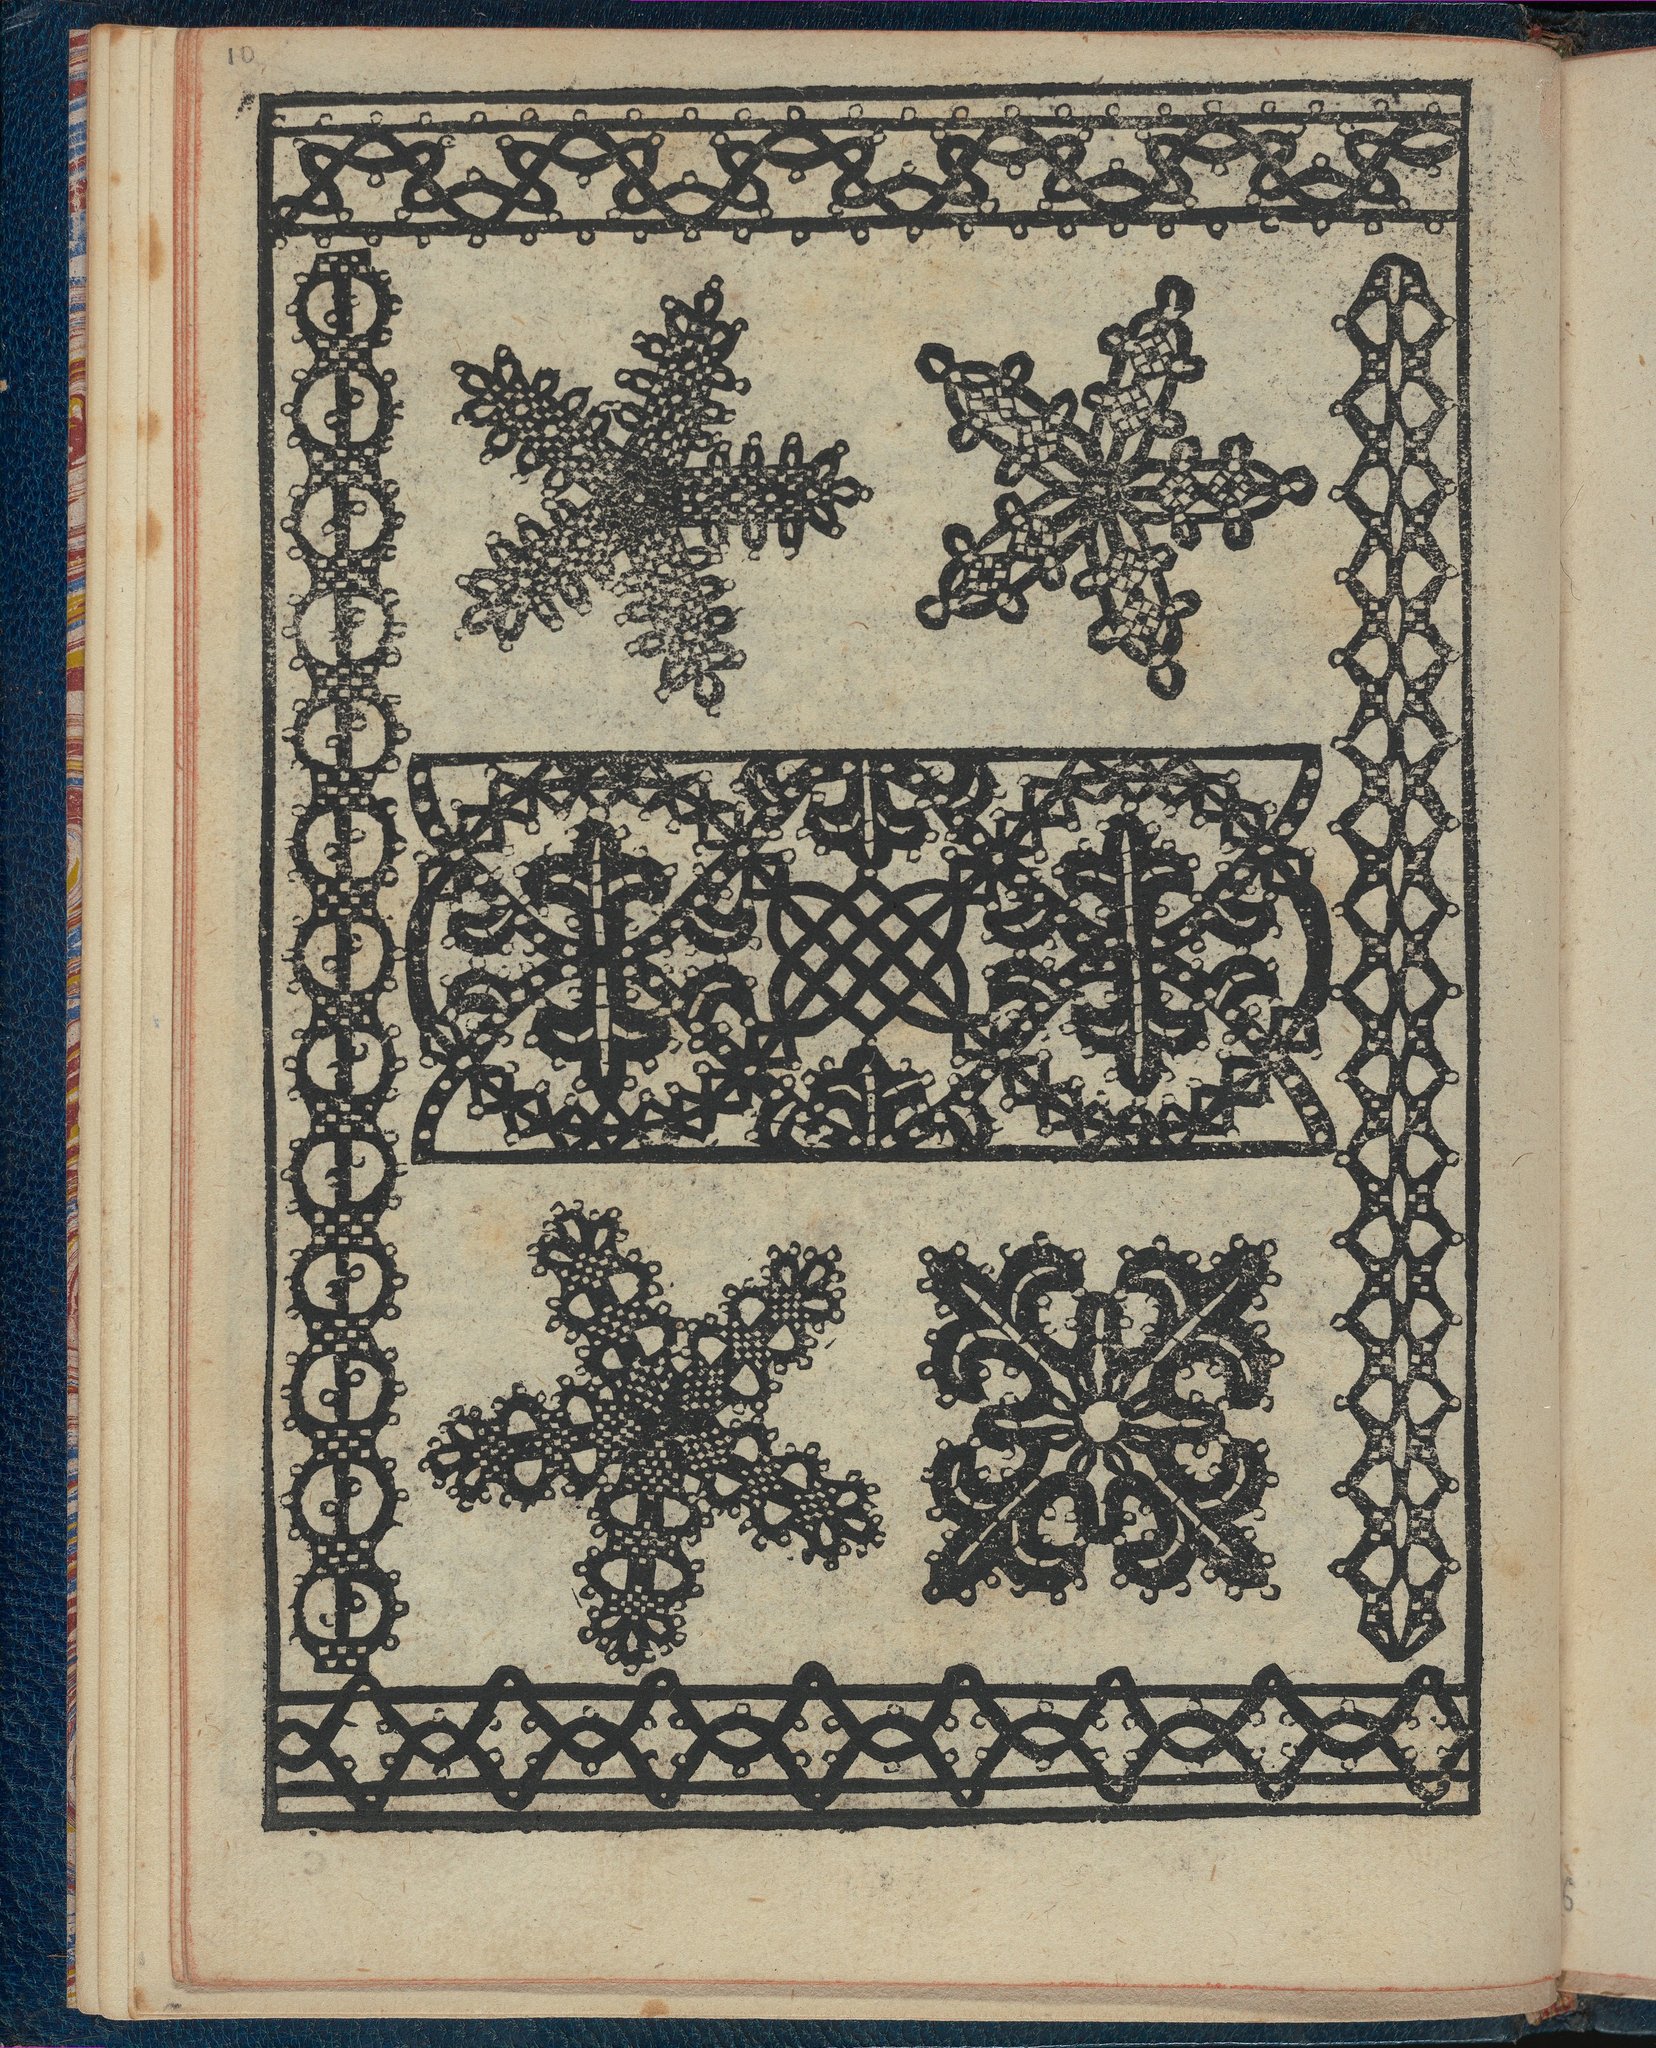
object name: book print ornament architecture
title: Le Pompe: Opera Nova, page 5 (verso)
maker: giovanni battista & marchio sessa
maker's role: publisher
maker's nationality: italian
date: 1557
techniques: woodcut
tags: flowers